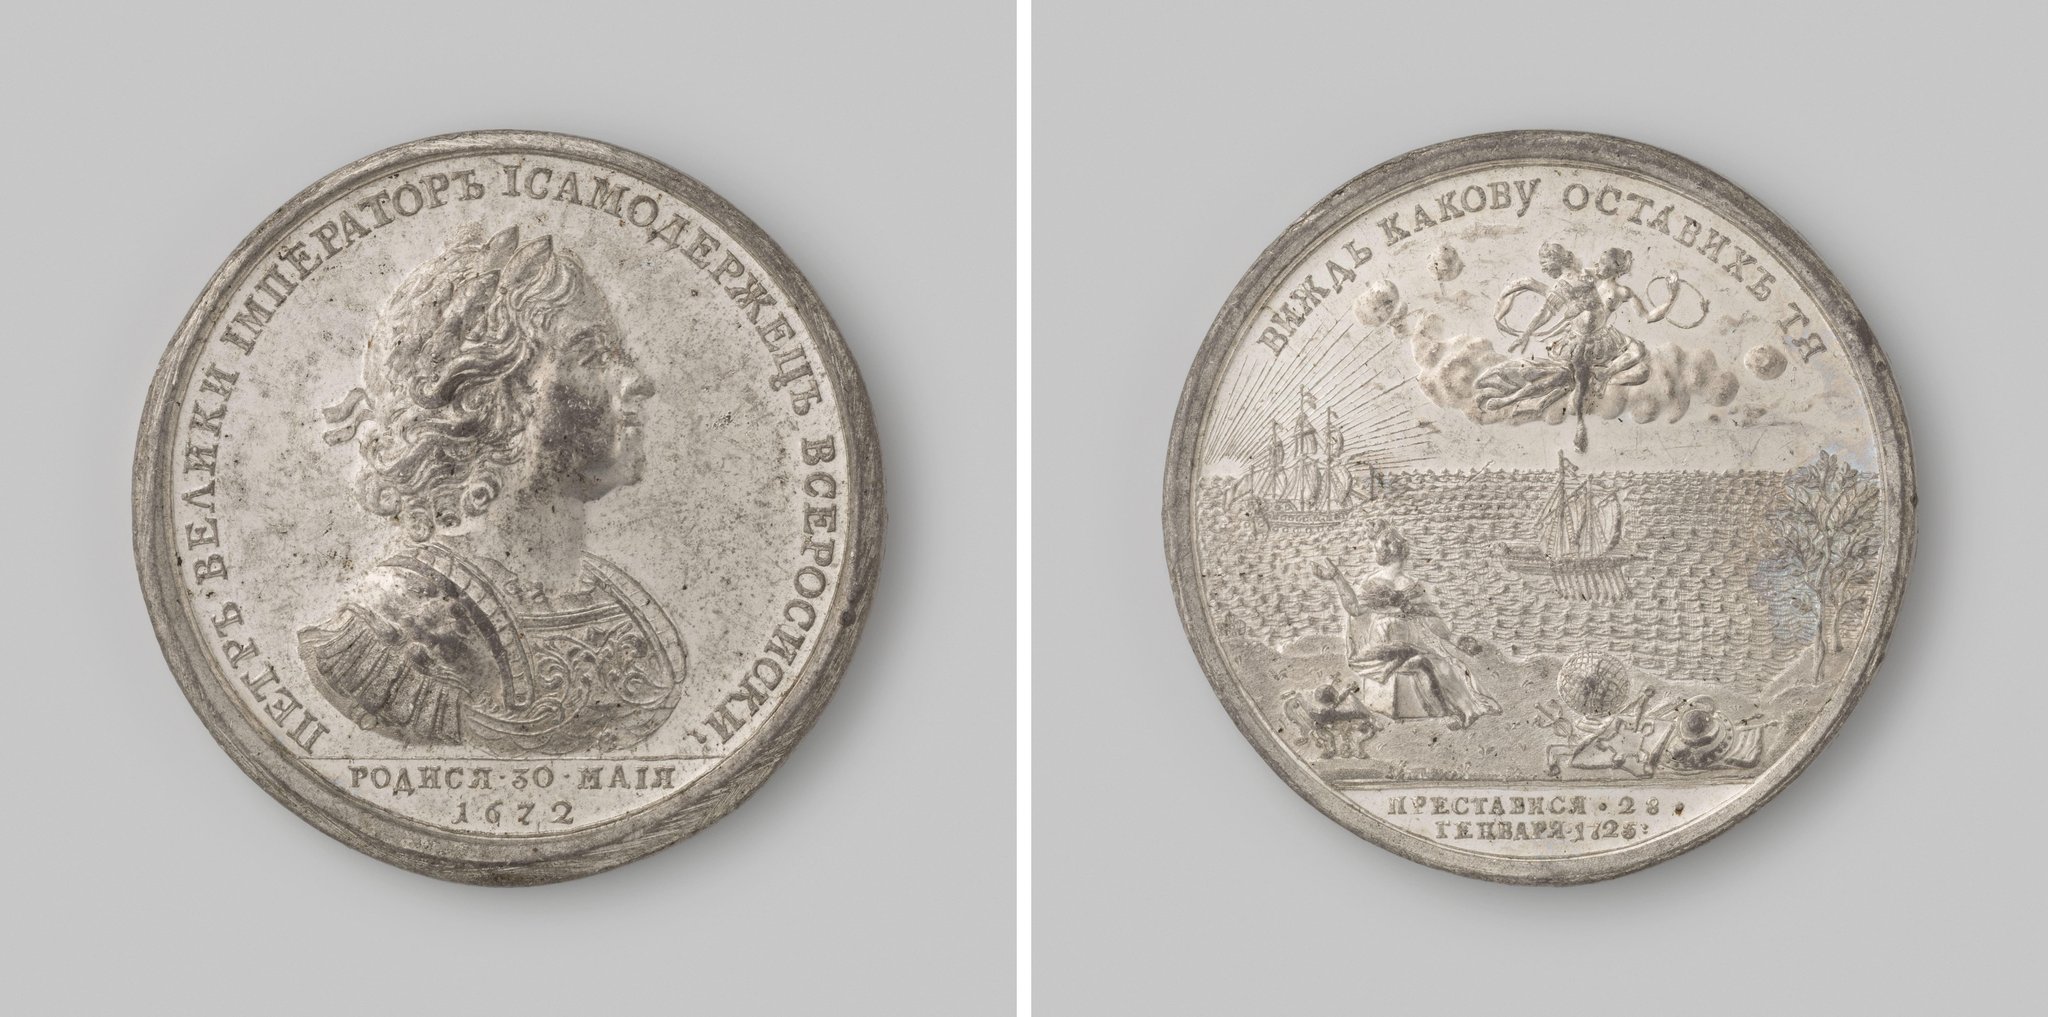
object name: history medal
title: Overlijden van Tsaar Peter I de Grote 1725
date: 1725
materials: tin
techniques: striking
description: Tinnen penning, op de voorzijde het borstbeeld van Tsaar Peter de Grote naar rechts met omschrift, op de keerzijde Tsaar Peter op een wolk ten hemel gevoerd, waaronder de tronende gekroonde Tsarina naast een tafel met globe en scepter, op een strand met symbolen van handel, zeevaart en krijgskunst, schepen op de achtergrond, met omschrift en afsnedetekst.